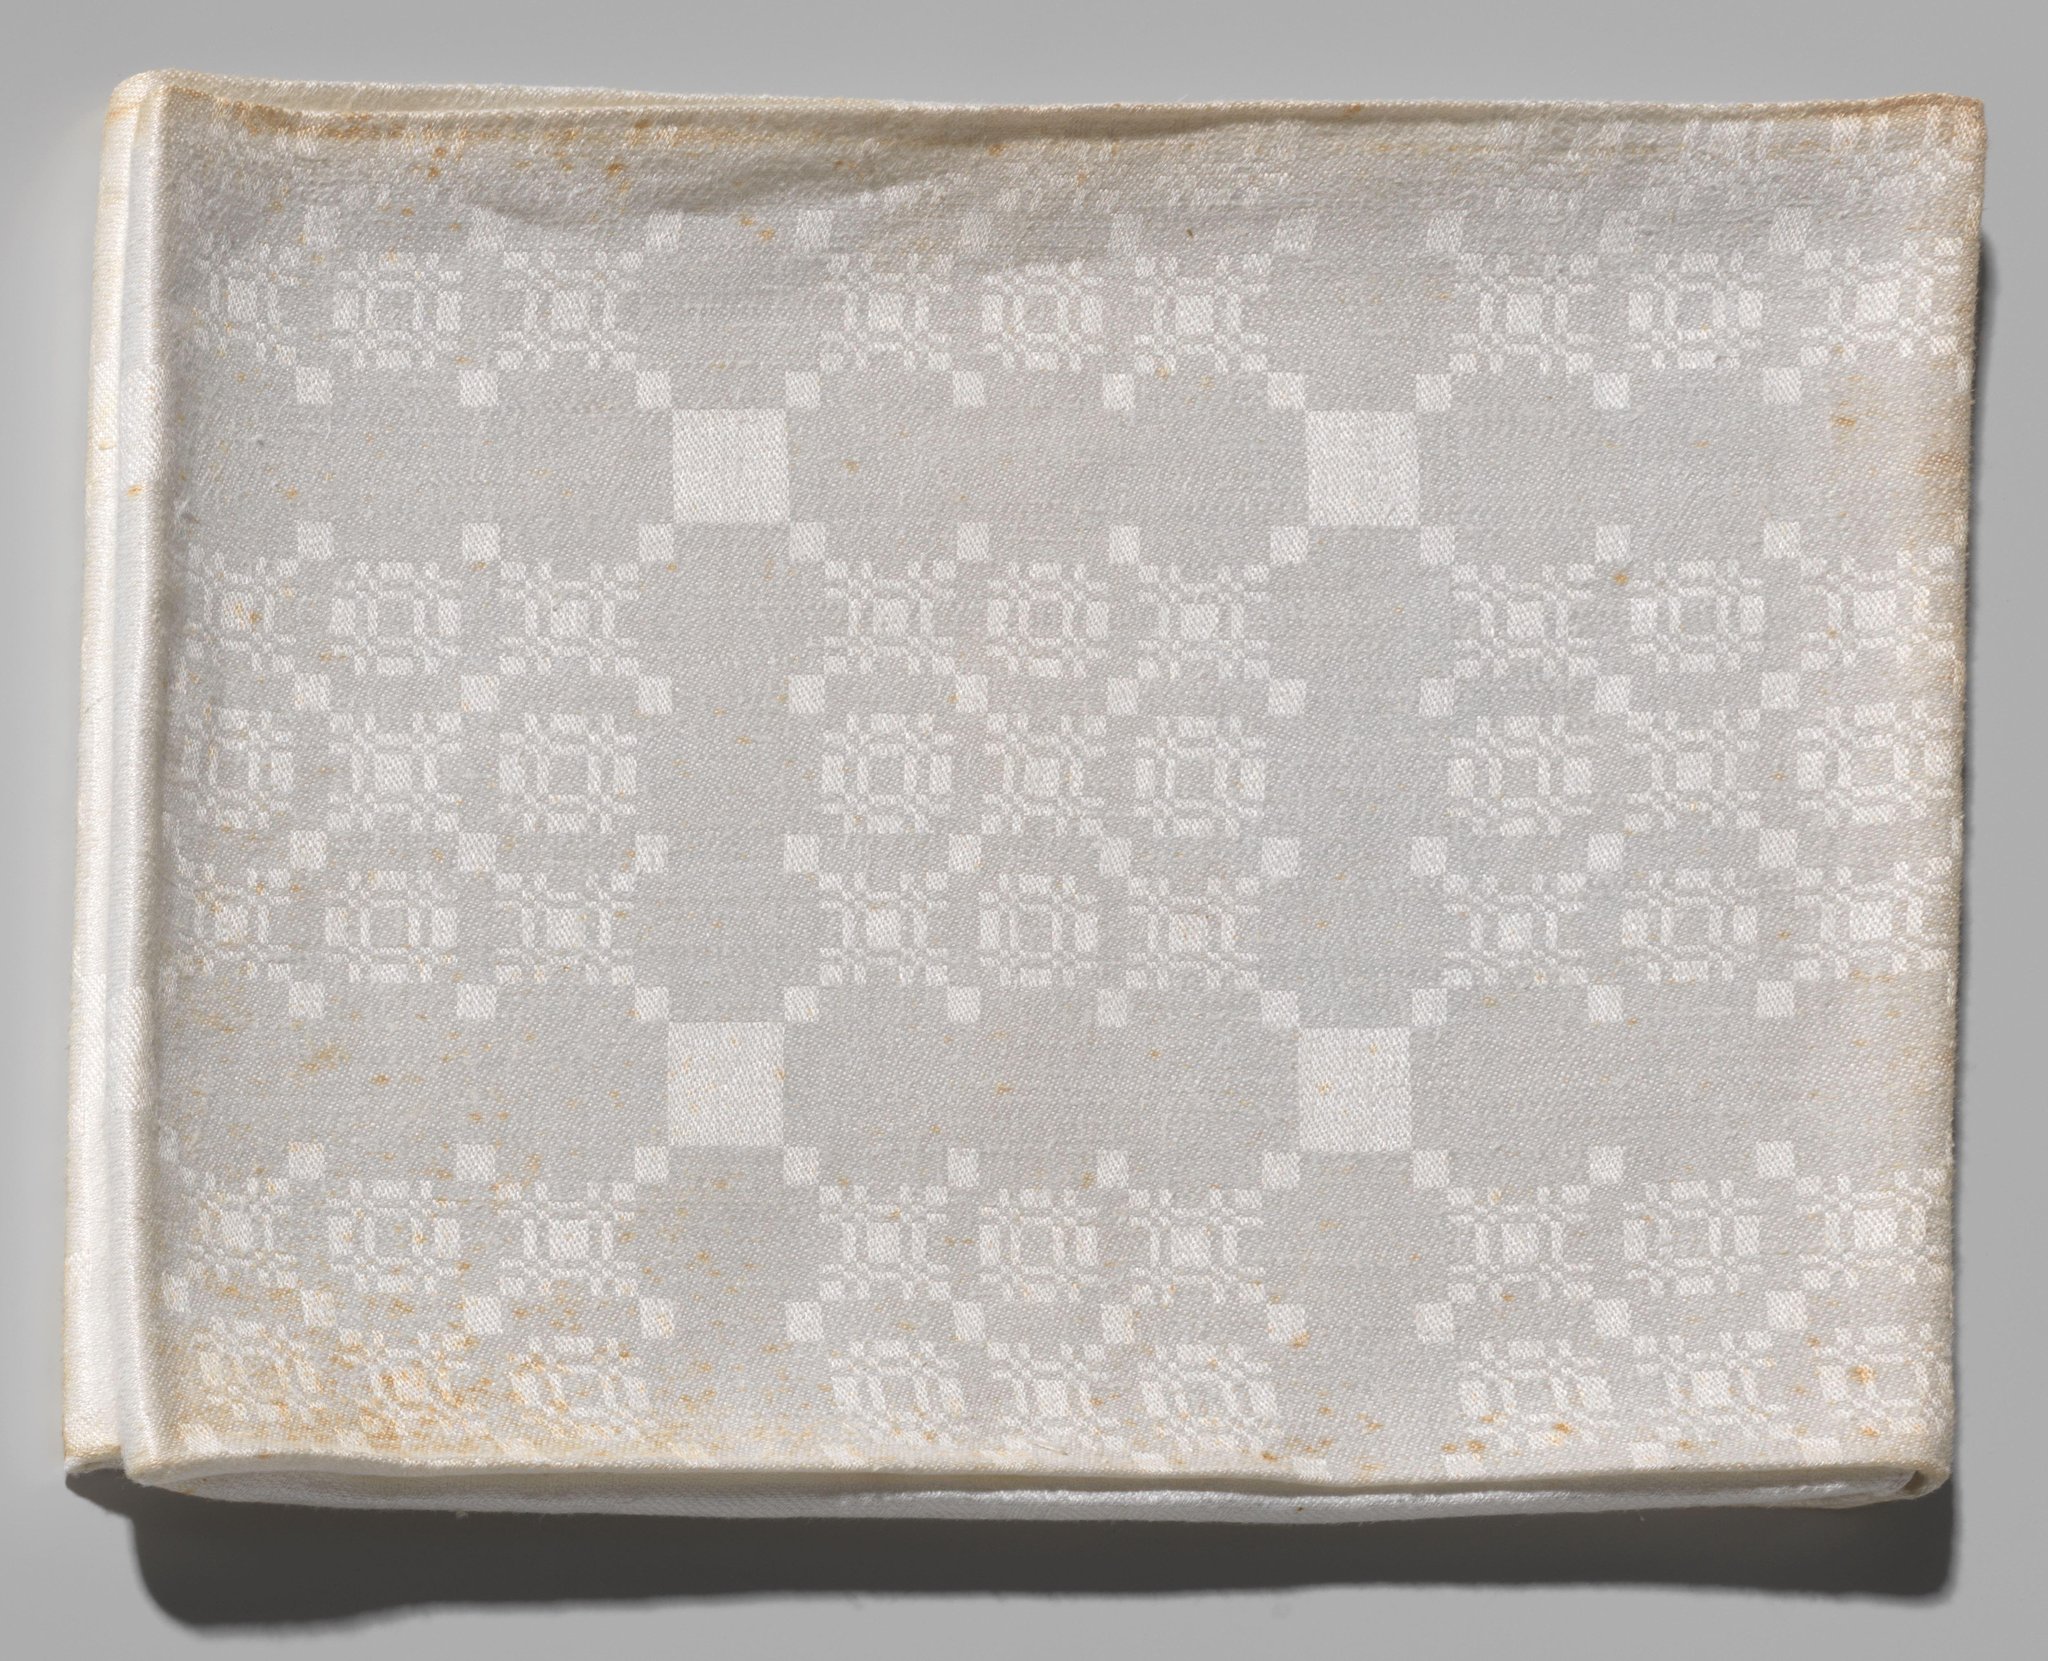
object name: napkin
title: Servet van linnen met pellenpatroon en randen rondom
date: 1700-1799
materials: linen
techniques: peeled fabric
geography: netherlands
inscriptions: : ‘100’, : ‘WS’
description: Servet van linnen met pellenpatroon en randen rondom. Een blok van drie maal drie pellen, om en om beeld en tegenbeeld, met een blok op de hoeken van drie patronen. Op de hoeken van deze figuren een reuze 'speldenkussen'. Merken: oorspronkelijk blauwe kruissteek WS en 100.